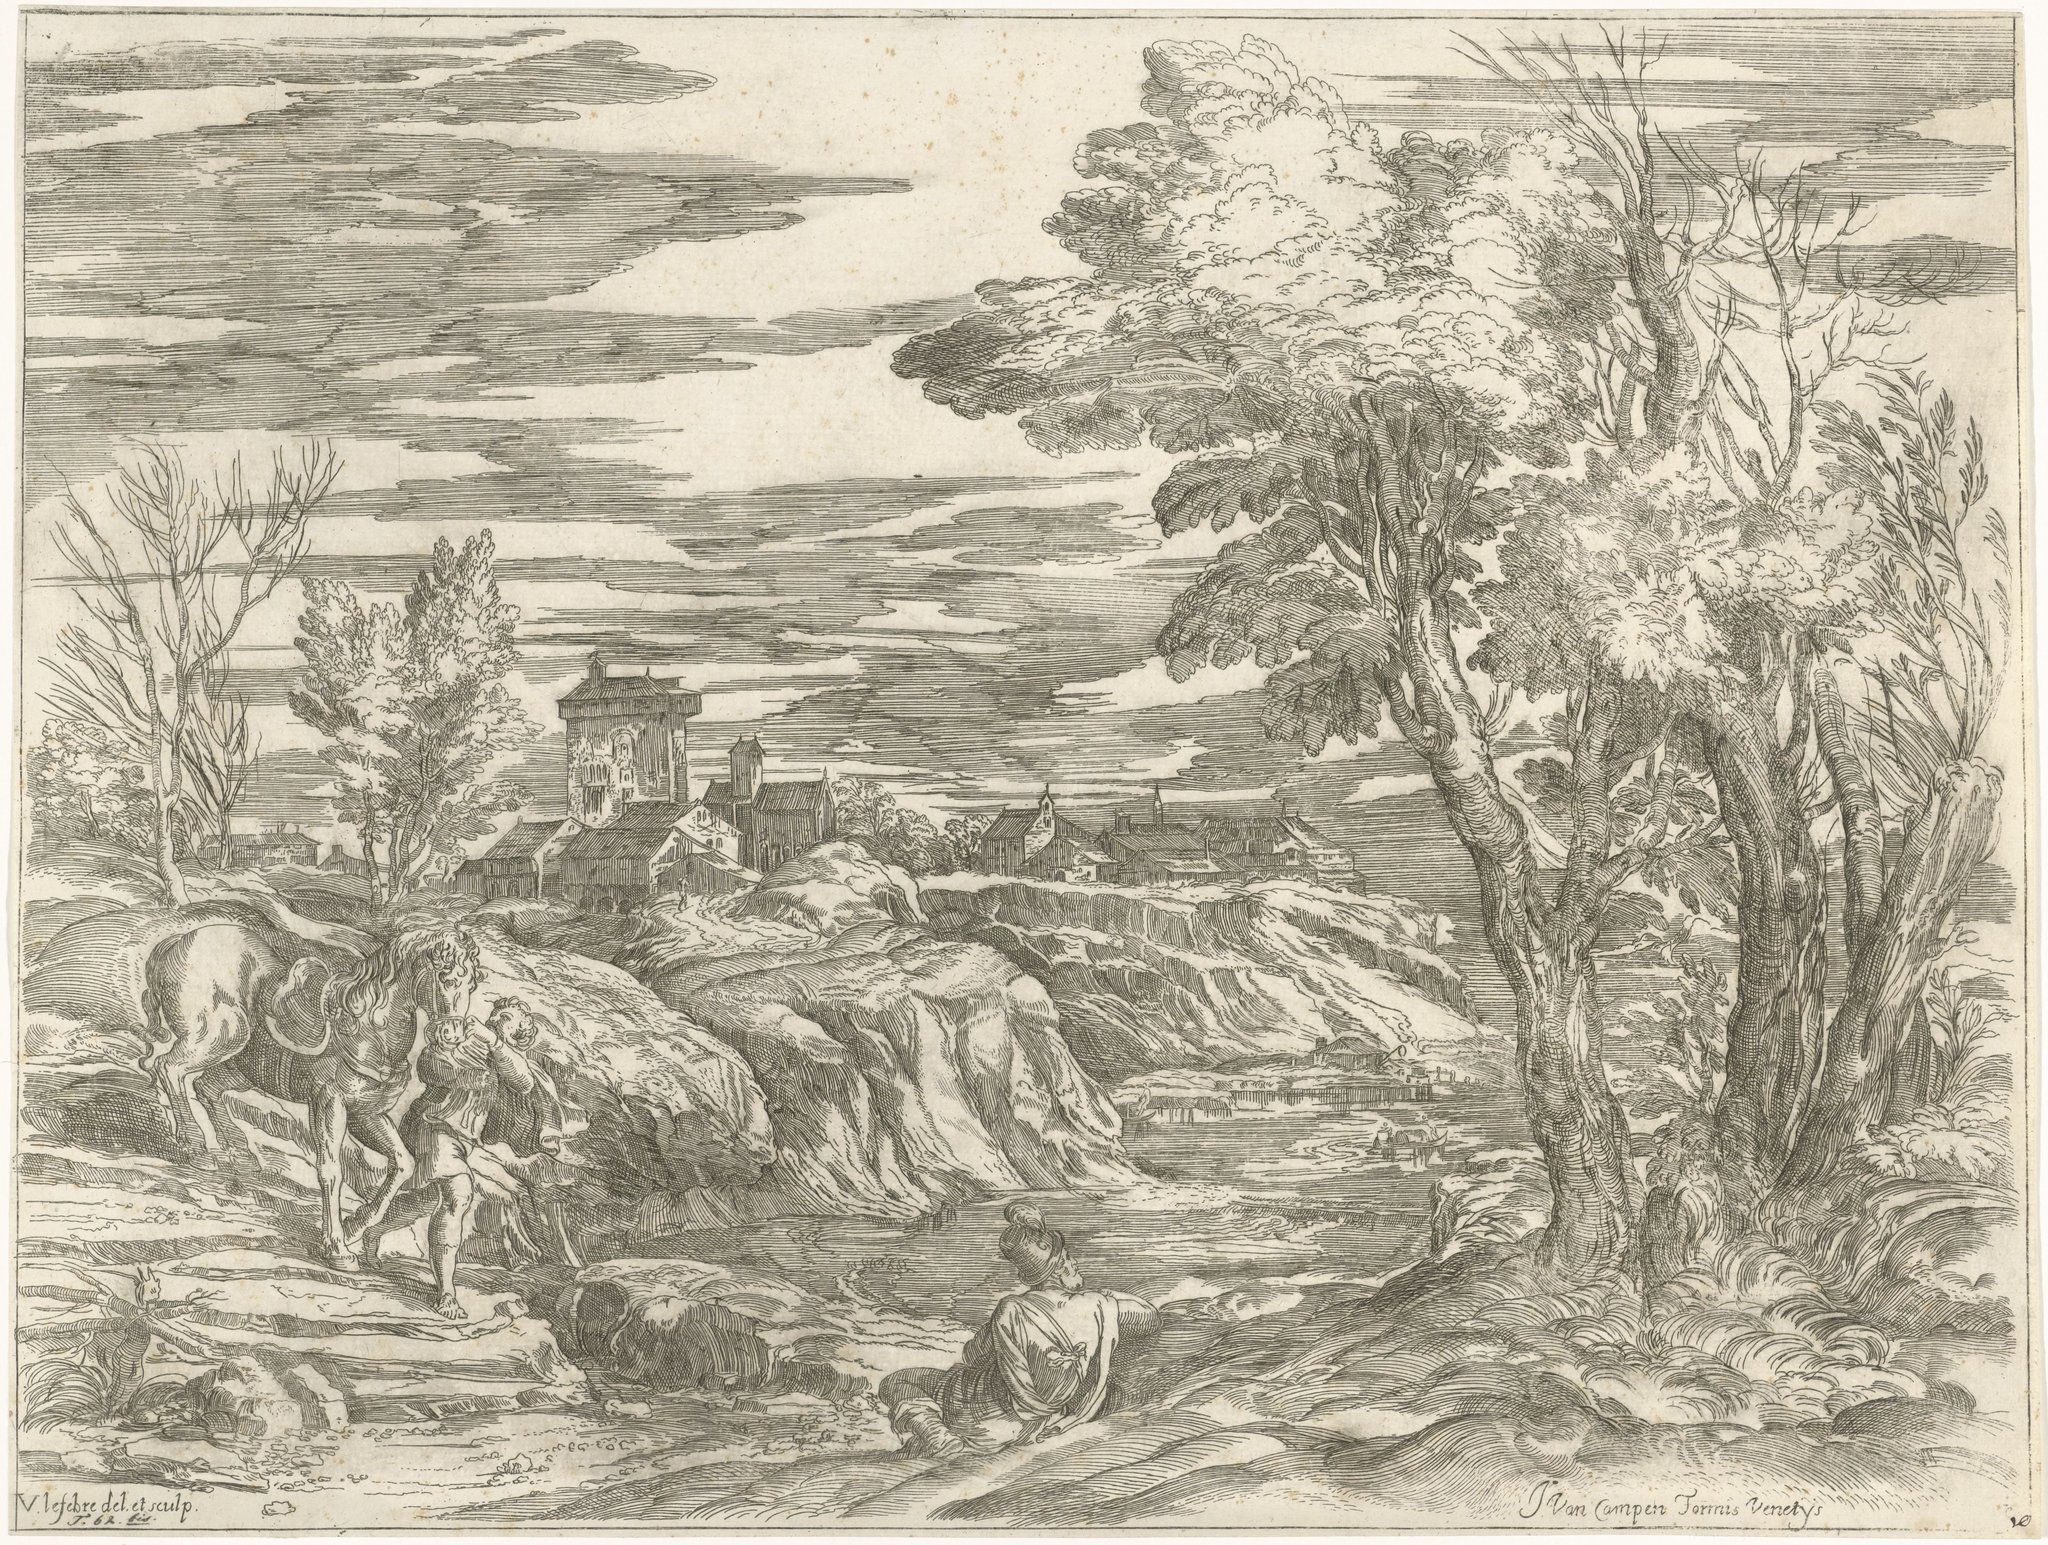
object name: print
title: Opera Selectiora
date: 1682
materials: paper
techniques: etching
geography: venice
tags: landscapes with waters, waterscapes, seascapes (in the temperate zone), leading a horse by the reins; rider beside his horse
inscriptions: collector's mark: Lugt 11, number: ‘10’, inscription: ‘T. 62. bis’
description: Rivierlandschap waarin een jongeman een paard aan leidsels meevoert. In het midden zit een man op de oever, in de verte liggen huizen. De prent maakt deel uit van een 53-delige serie prenten naar schilderijen van Titiaan en Veronese.